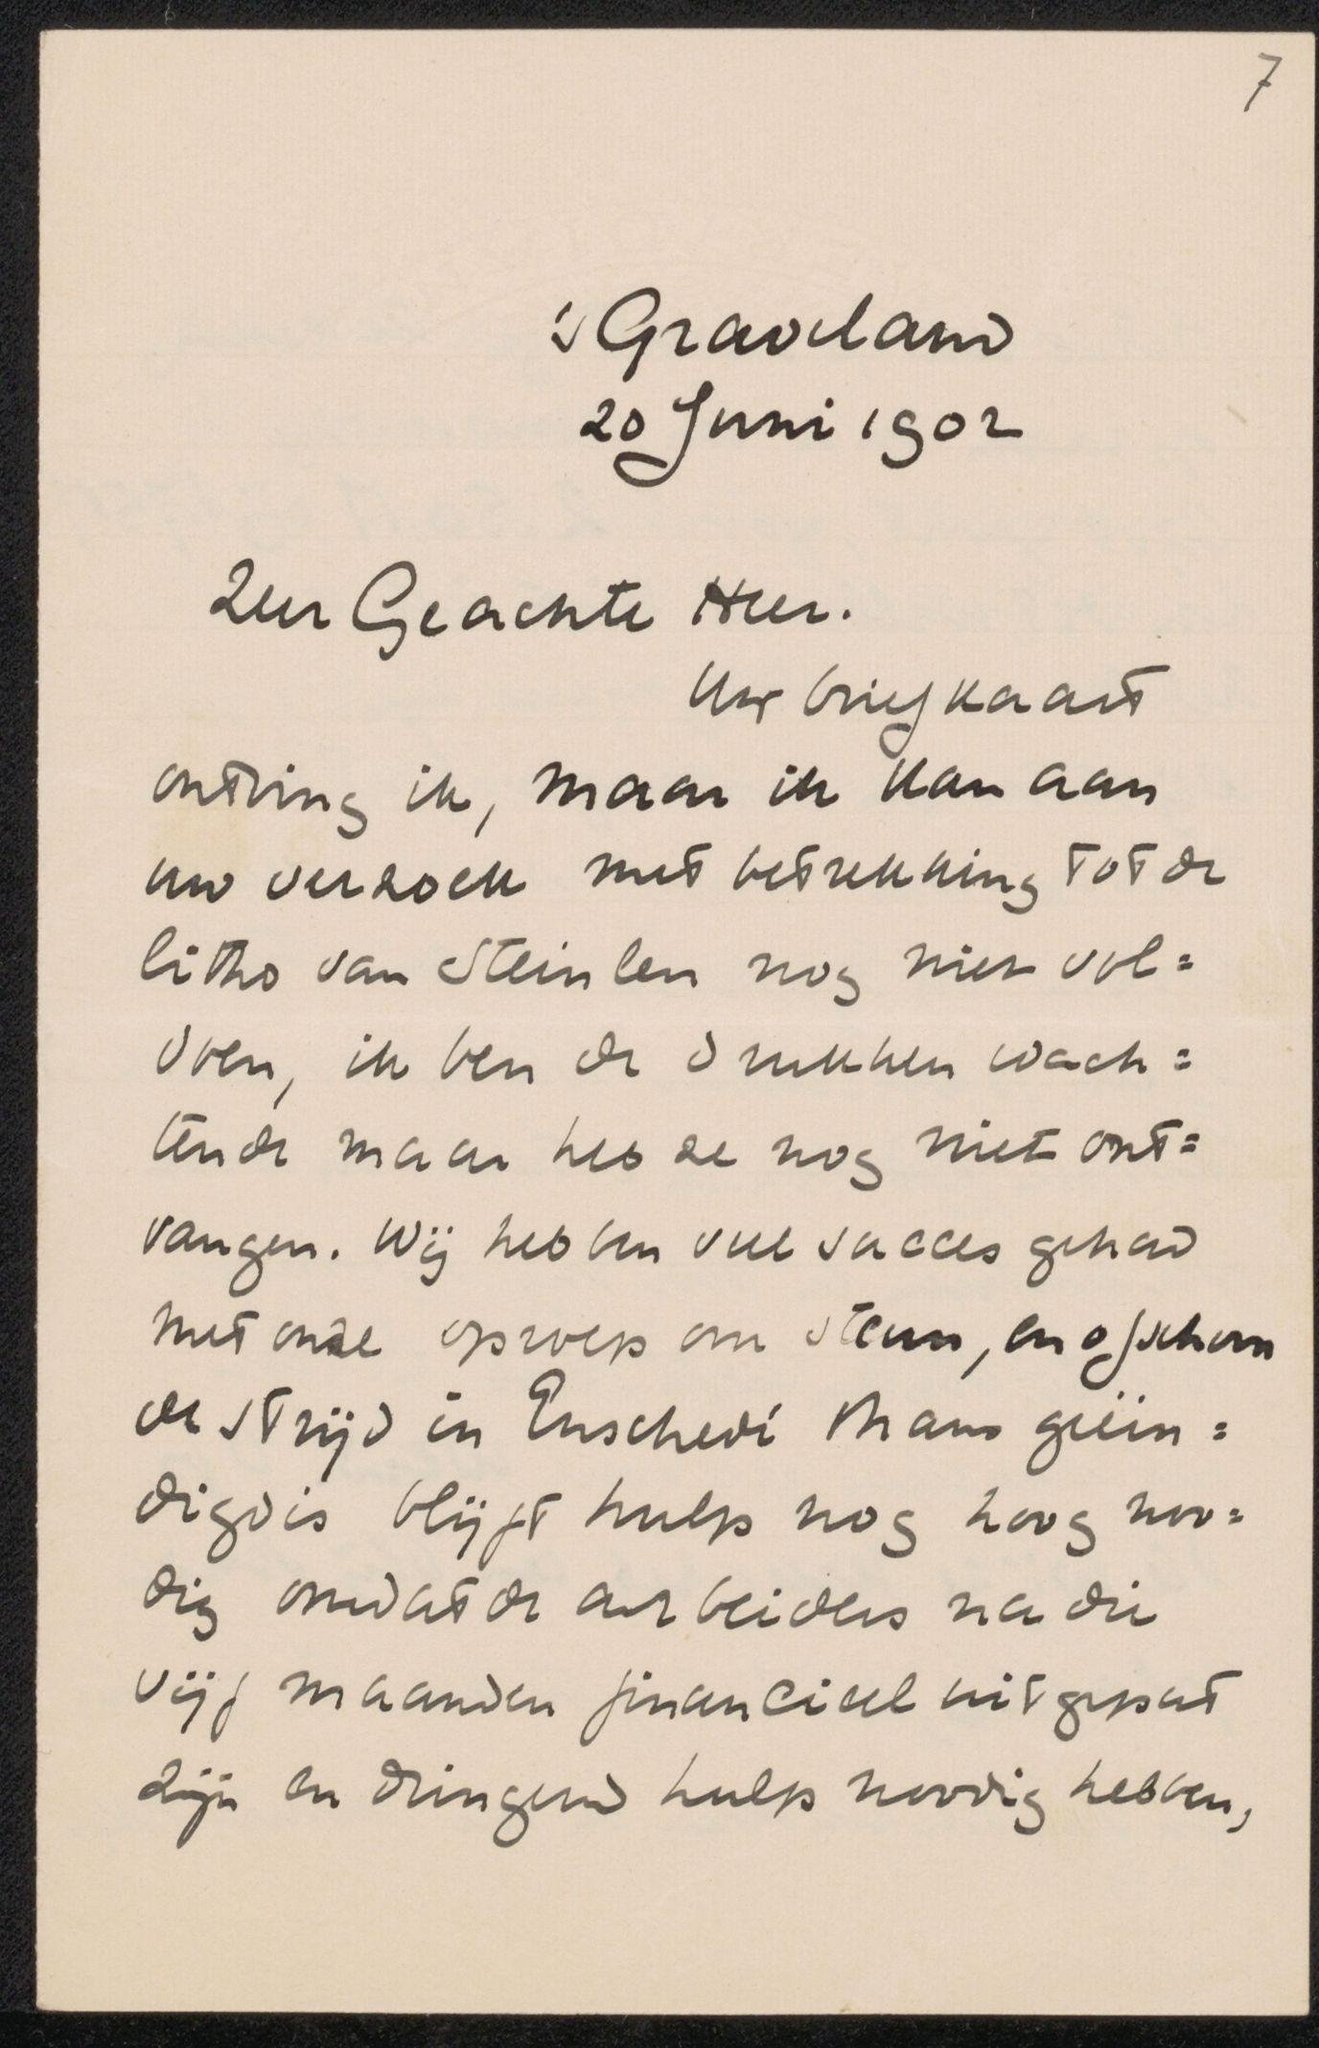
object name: letter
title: Brief aan Pieter Haverkorn van Rijsewijk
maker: richard nicolaüs roland holst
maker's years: 1868-1938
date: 1902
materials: ink, paper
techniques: pen, writing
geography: s-graveland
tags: designer, jan veth, den bosch, amsterdam, painter, print maker, draughtsman, antoon derkinderen, paris, sculptor, théophile alexandre steinlen, pieter haverkorn van rijsewijk, drawing, applied arts, arts and crafts; industrial design, the graphic arts, money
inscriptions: collector's mark: ‘RPK’